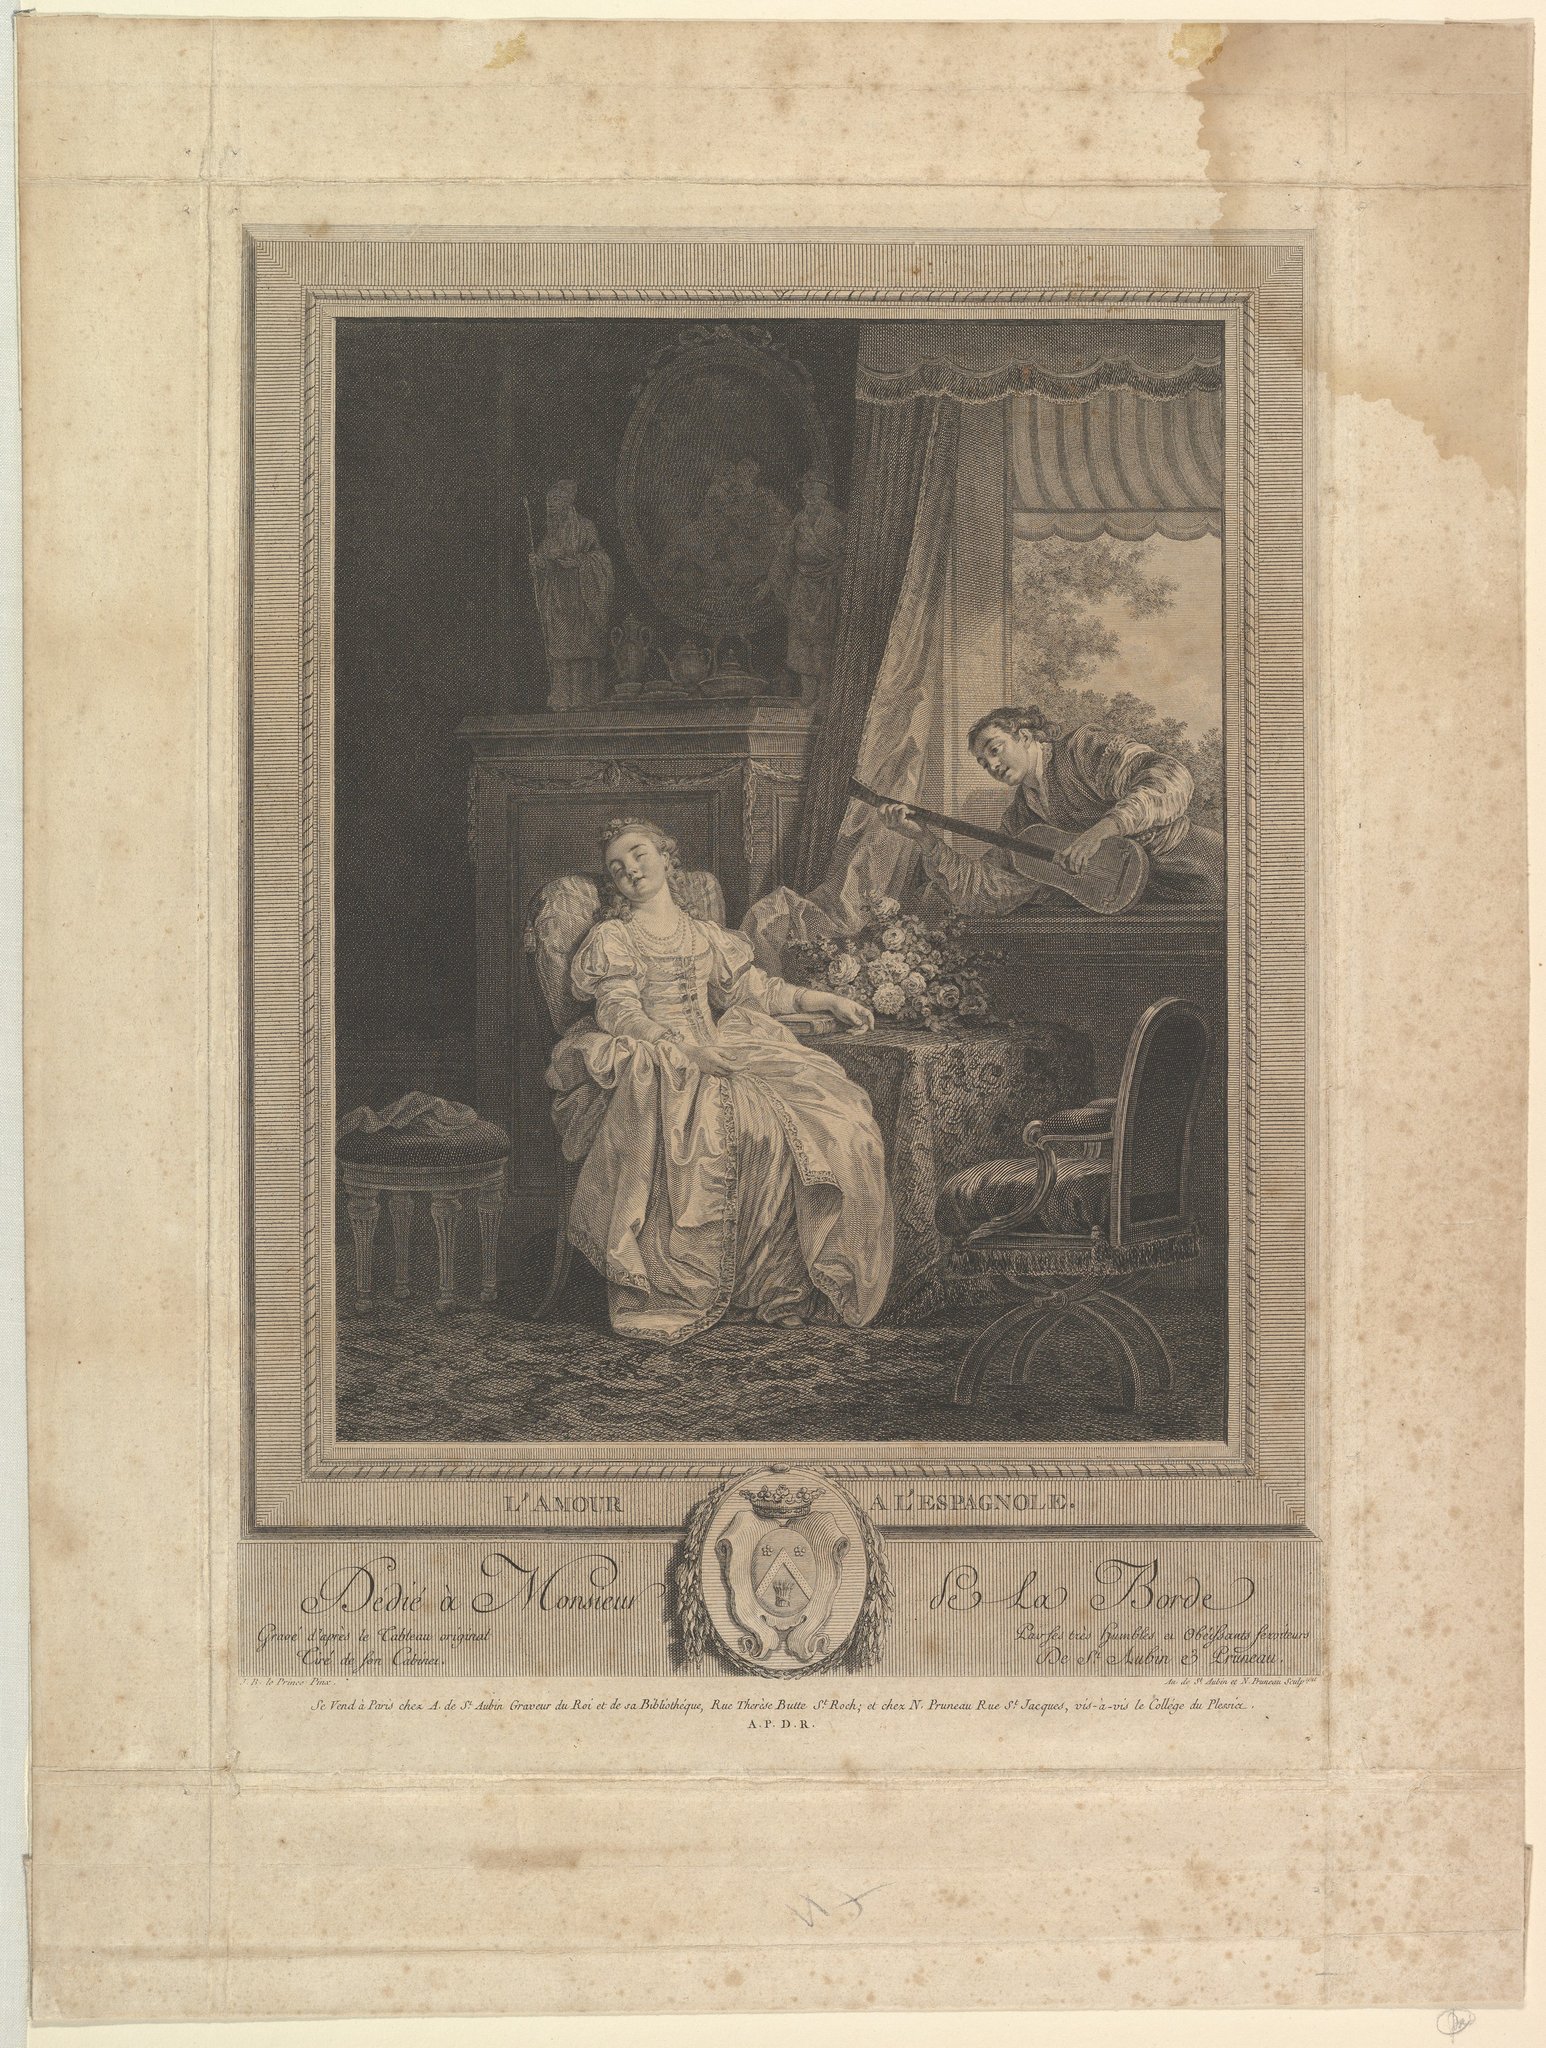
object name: print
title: L'Amour a L'Espagnole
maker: augustin de saint-aubin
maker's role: artist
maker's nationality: french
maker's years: 1736-1807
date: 1780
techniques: engraving, etching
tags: musical instruments,men,women